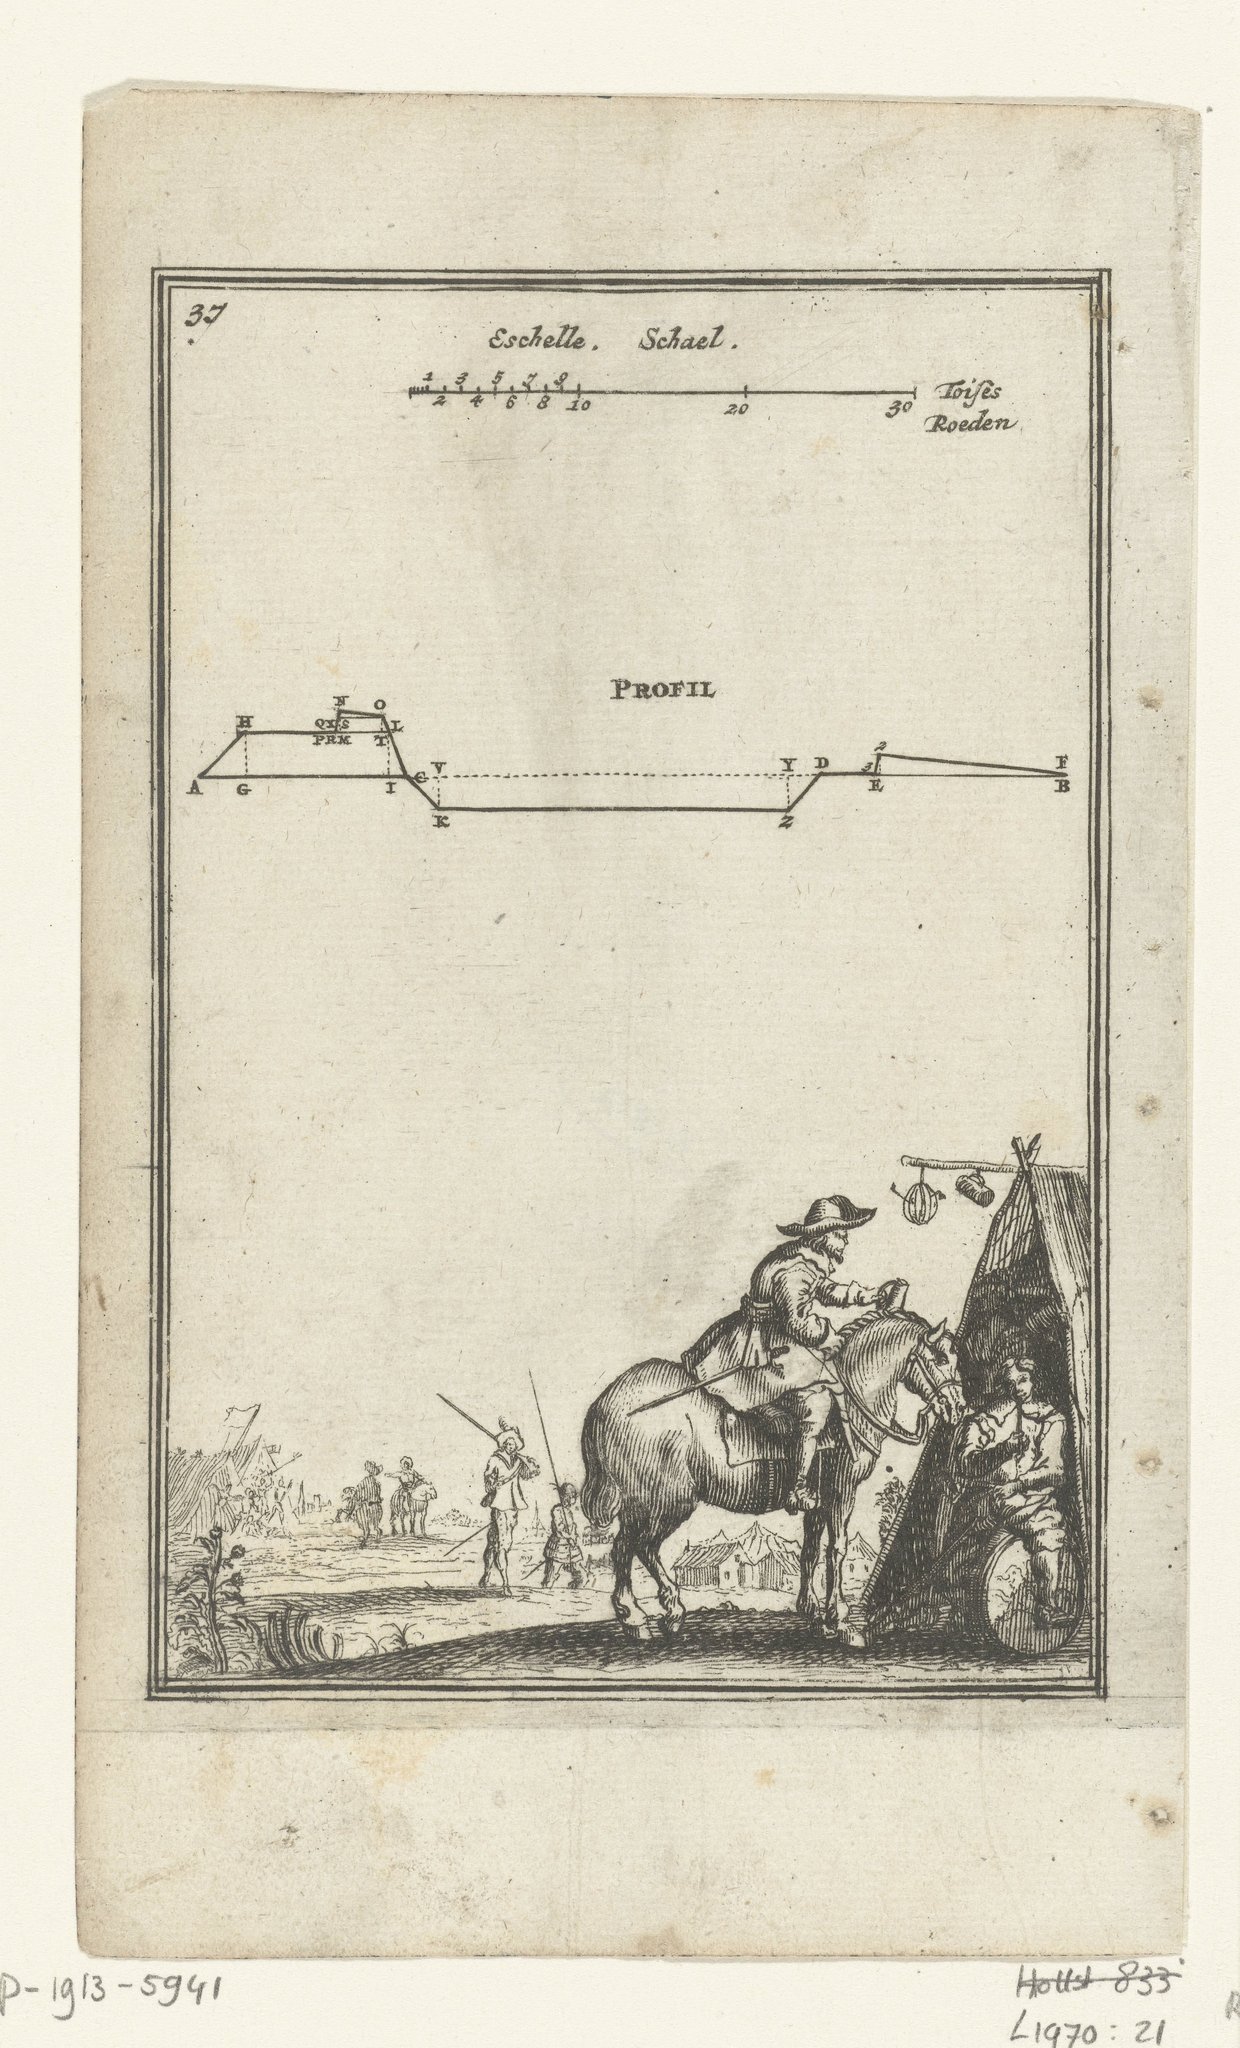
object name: print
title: Illustratie voor 'Den Arbeid van Mars' van Allain Manesson Mallet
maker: romeyn de hooghe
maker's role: draughtsman, goldsmith, painter, print maker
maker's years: 1645-1708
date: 1672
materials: paper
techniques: etching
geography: amsterdam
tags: warfare; military affairs (+ cavalry, horsemen), fortifications, military engineering, mathematics, male sutler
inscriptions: collector's mark: Lugt 2228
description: Schematische weergave van een wal en een gracht. Daaronder een ruiter die een beker drinken komt halen bij een man op een ton voor een tent. In de hoek linksboven het cijfer 37 (= het nummer van de pagina in het boek waartegenover de illustratie geplaatst is).